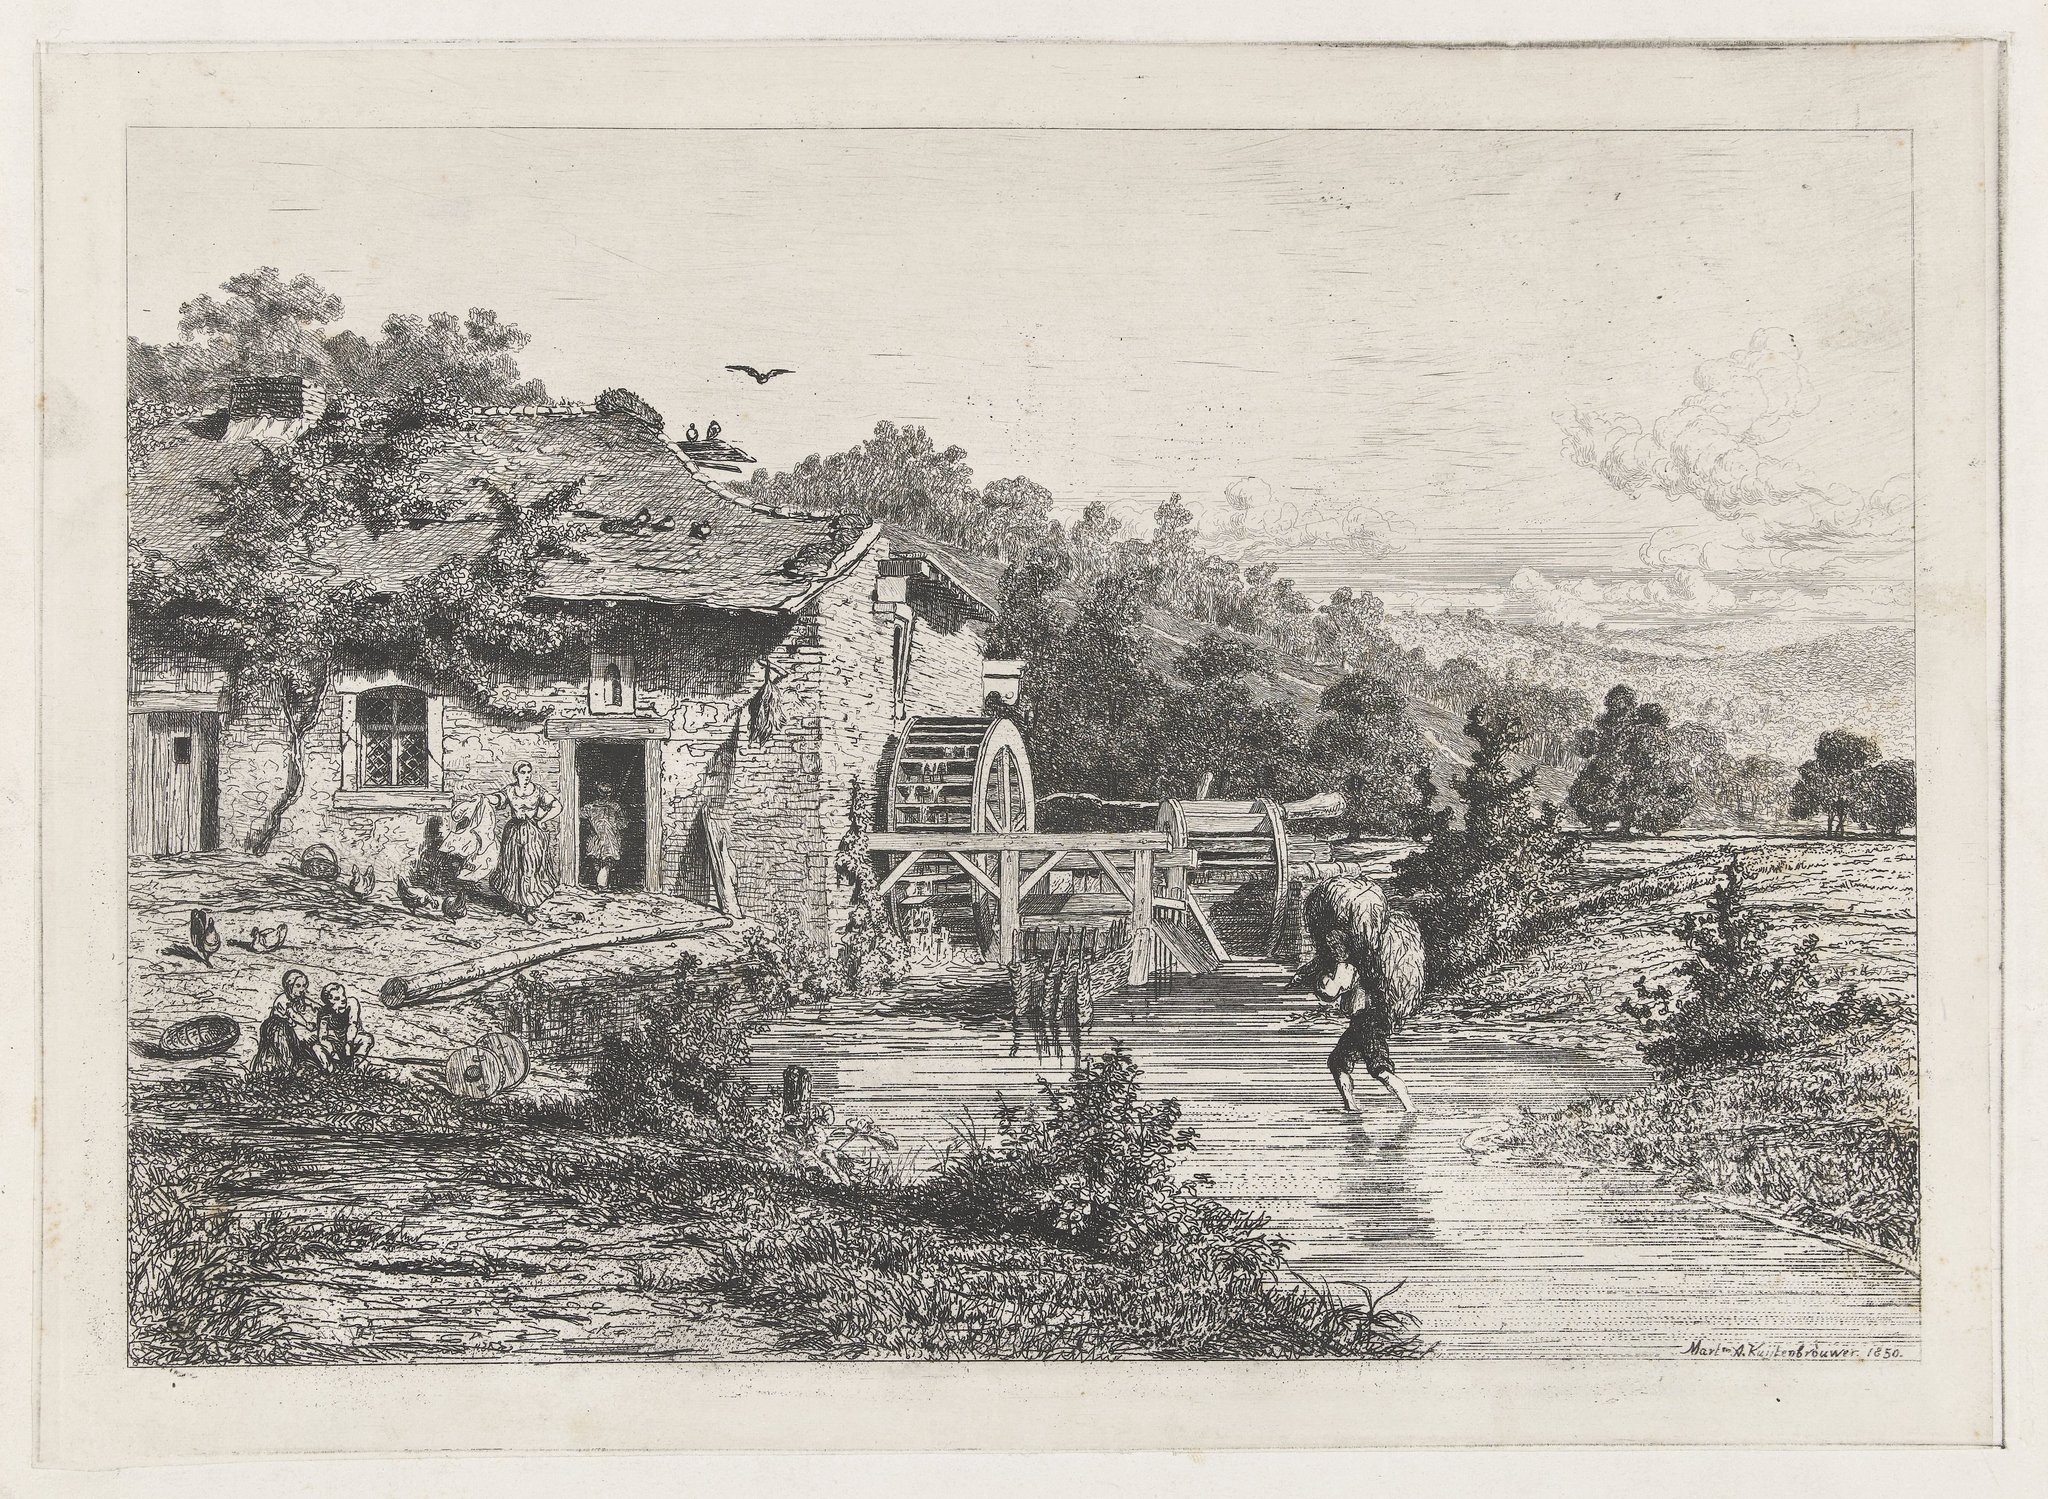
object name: print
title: Watermolen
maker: martinus antonius kuytenbrouwer jr.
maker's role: draughtsman, painter, print maker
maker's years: 1821-1897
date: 1850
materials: paper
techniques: etching, roulette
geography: brussels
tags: agricultural products and by-products: hay, farmers - aa - female farmer, farmer's wife, brook, fowl (cock, hen, chicken, etc.), watermill in landscape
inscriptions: collector's mark: Lugt 2228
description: Landschap met een watermolen aan een beek. In de beek loopt een man met een baal hooi op zijn rug. Op het erf voor de molen staat een boerin en lopen een paar kippen. Aan de waterkant twee spelende kinderen.